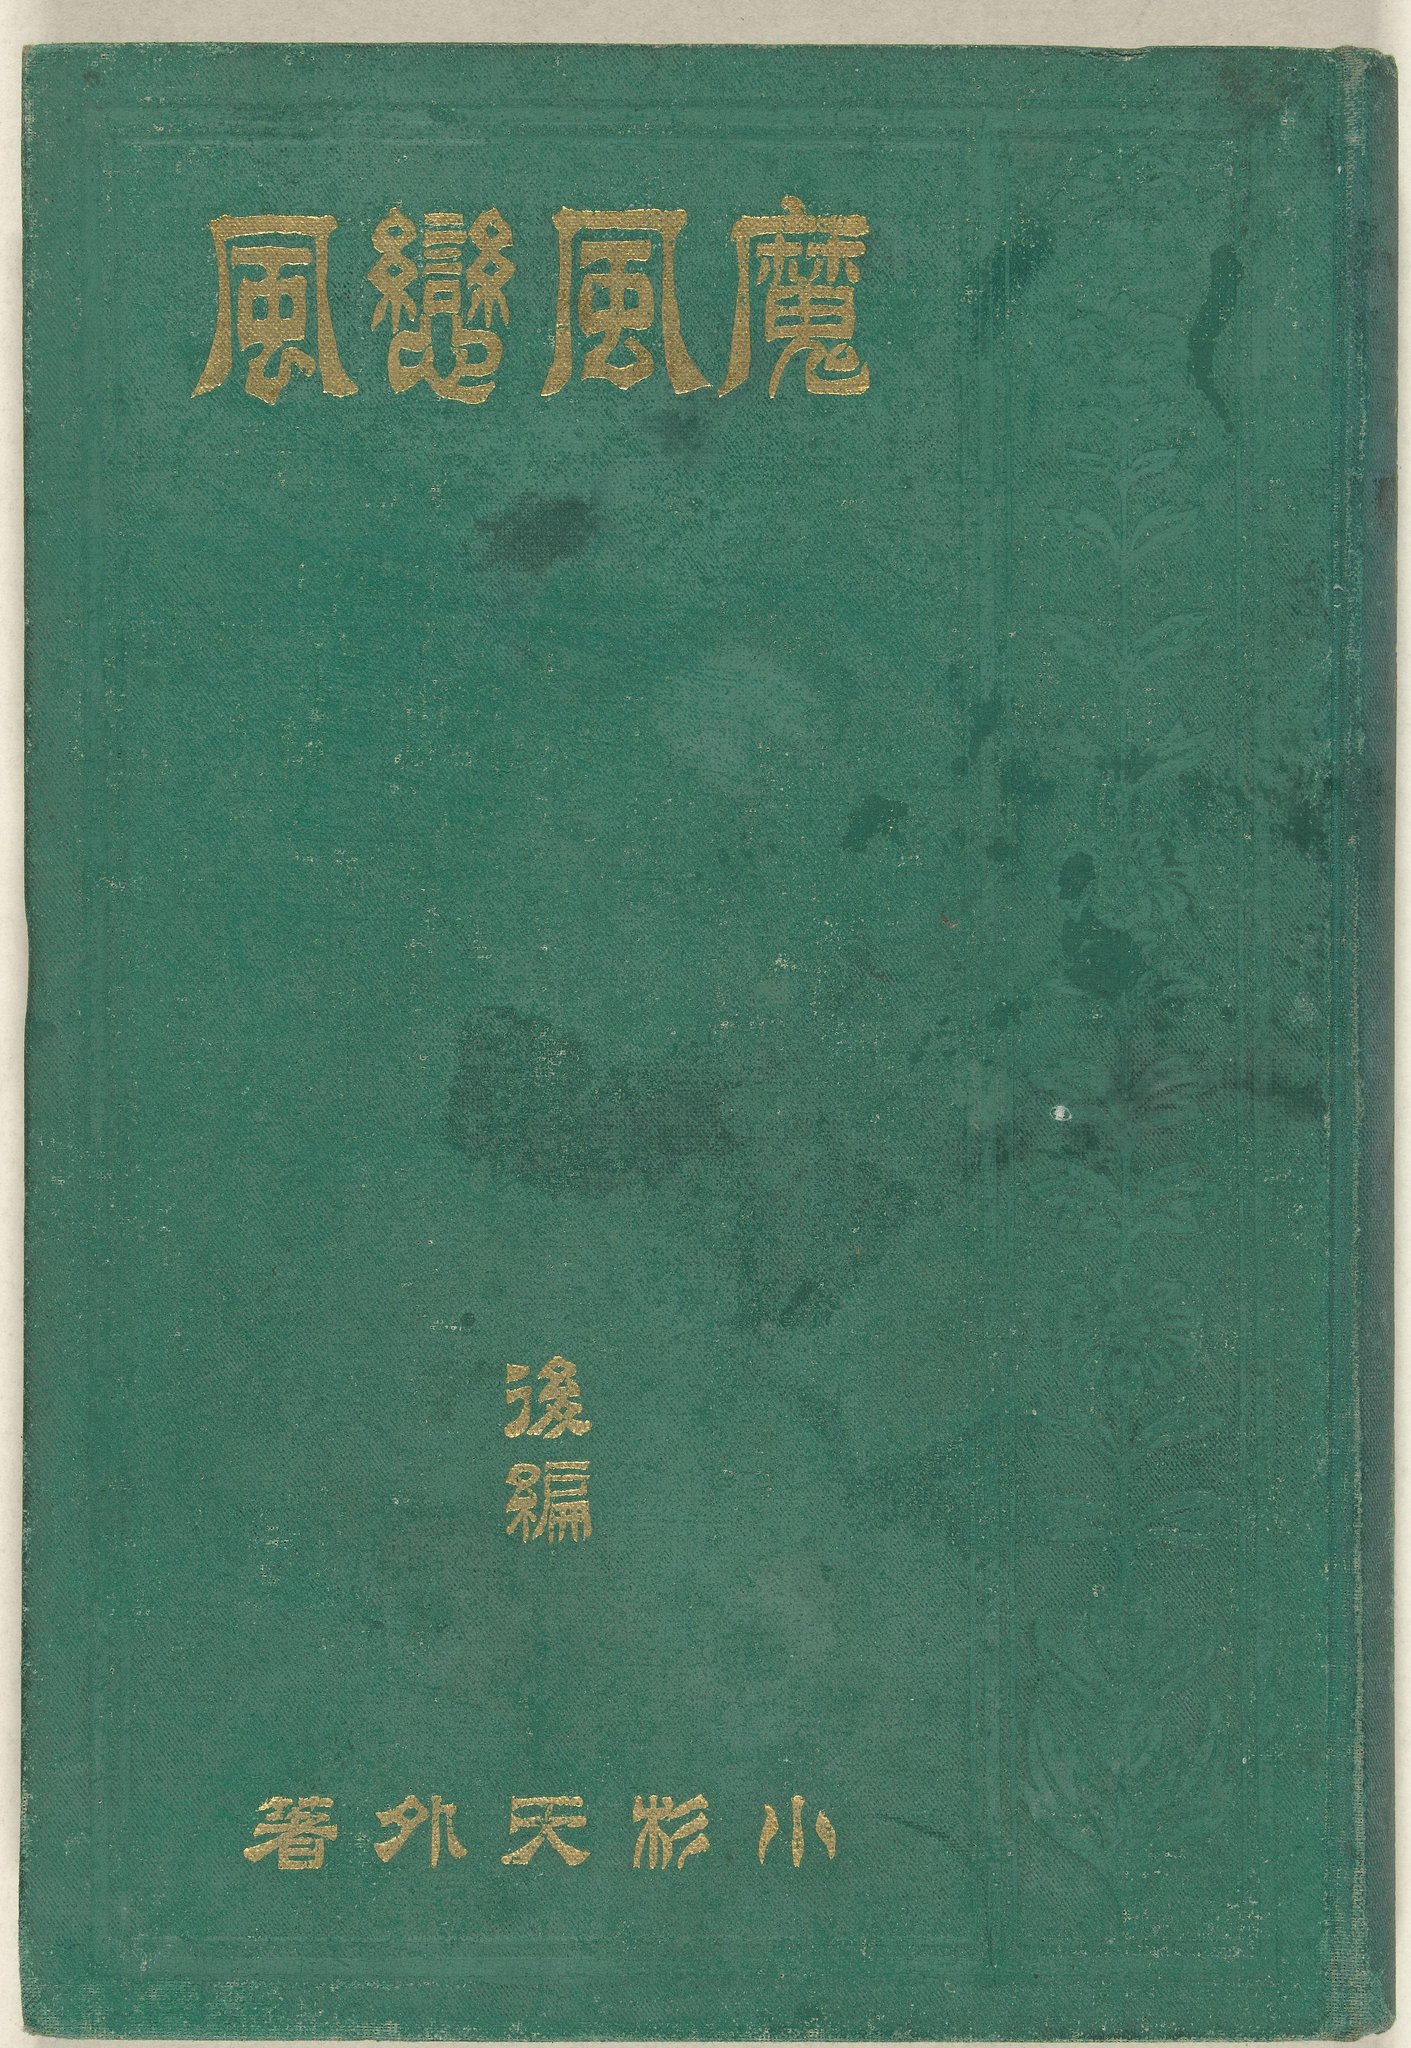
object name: book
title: Makaze koikaze - kohen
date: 1908-1910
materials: paper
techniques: letterpress printing, lithograph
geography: tokyo